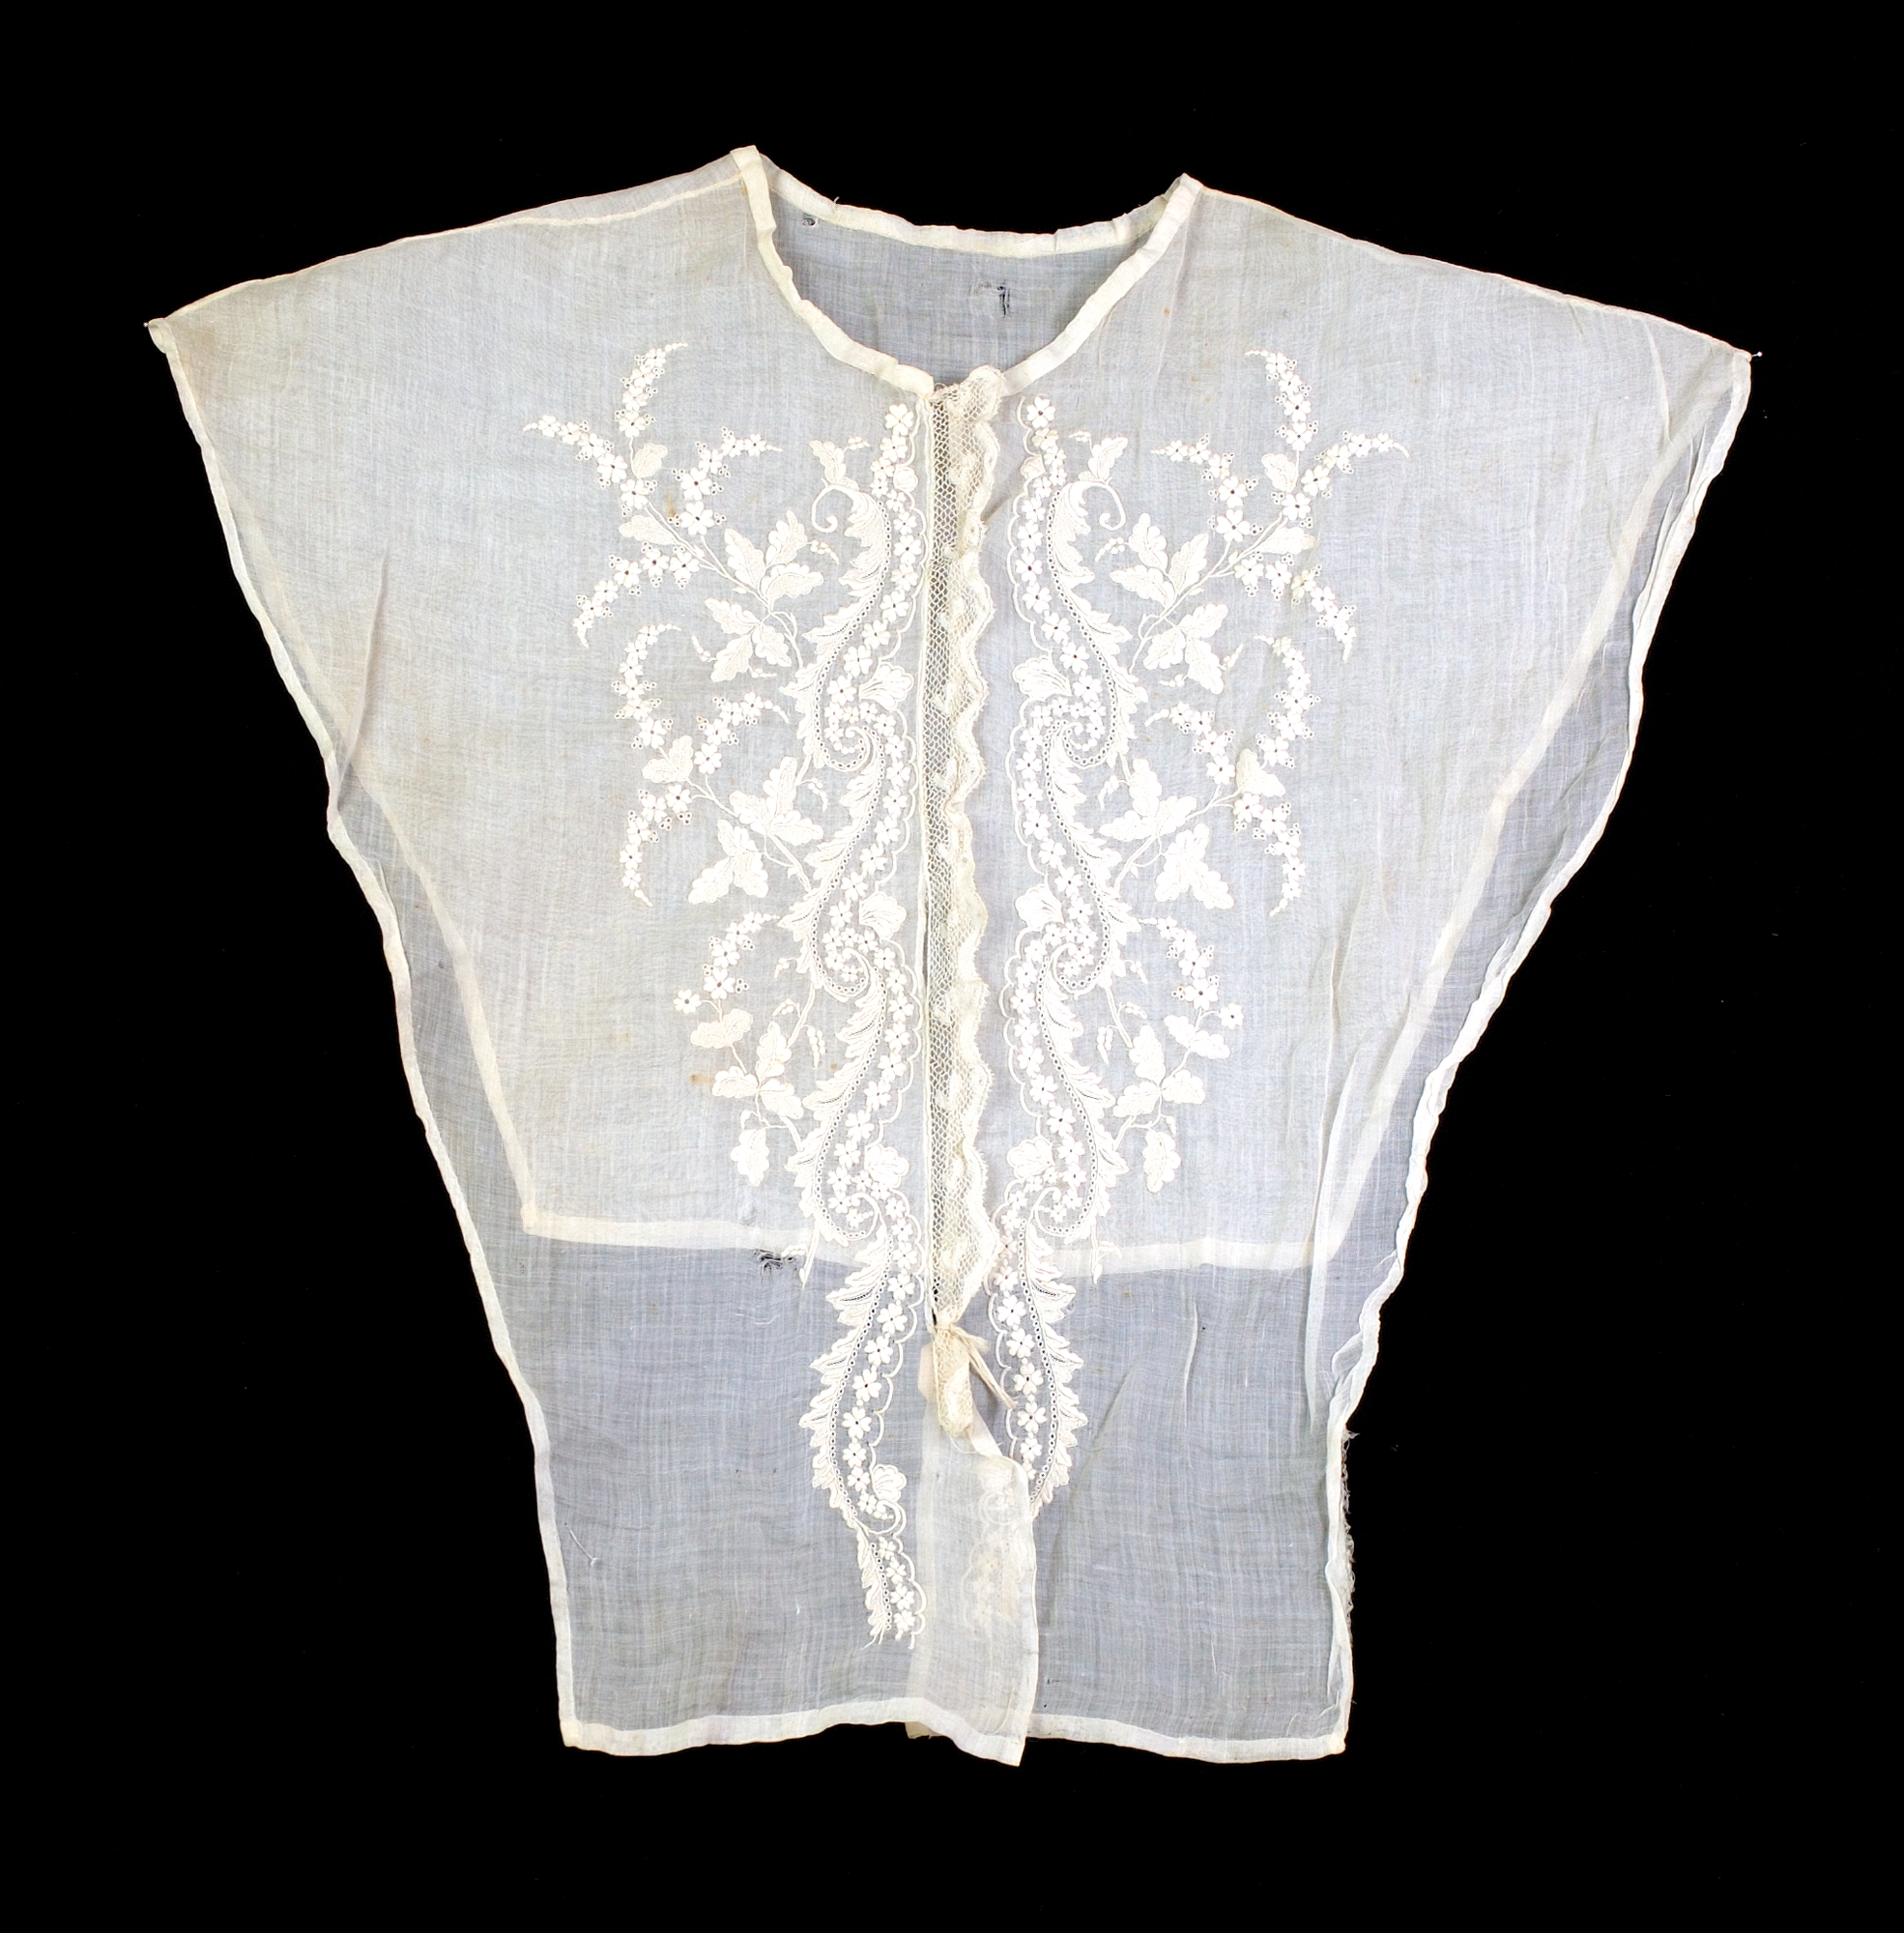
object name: chemise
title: Chemisette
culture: american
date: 1835-1840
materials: cotton